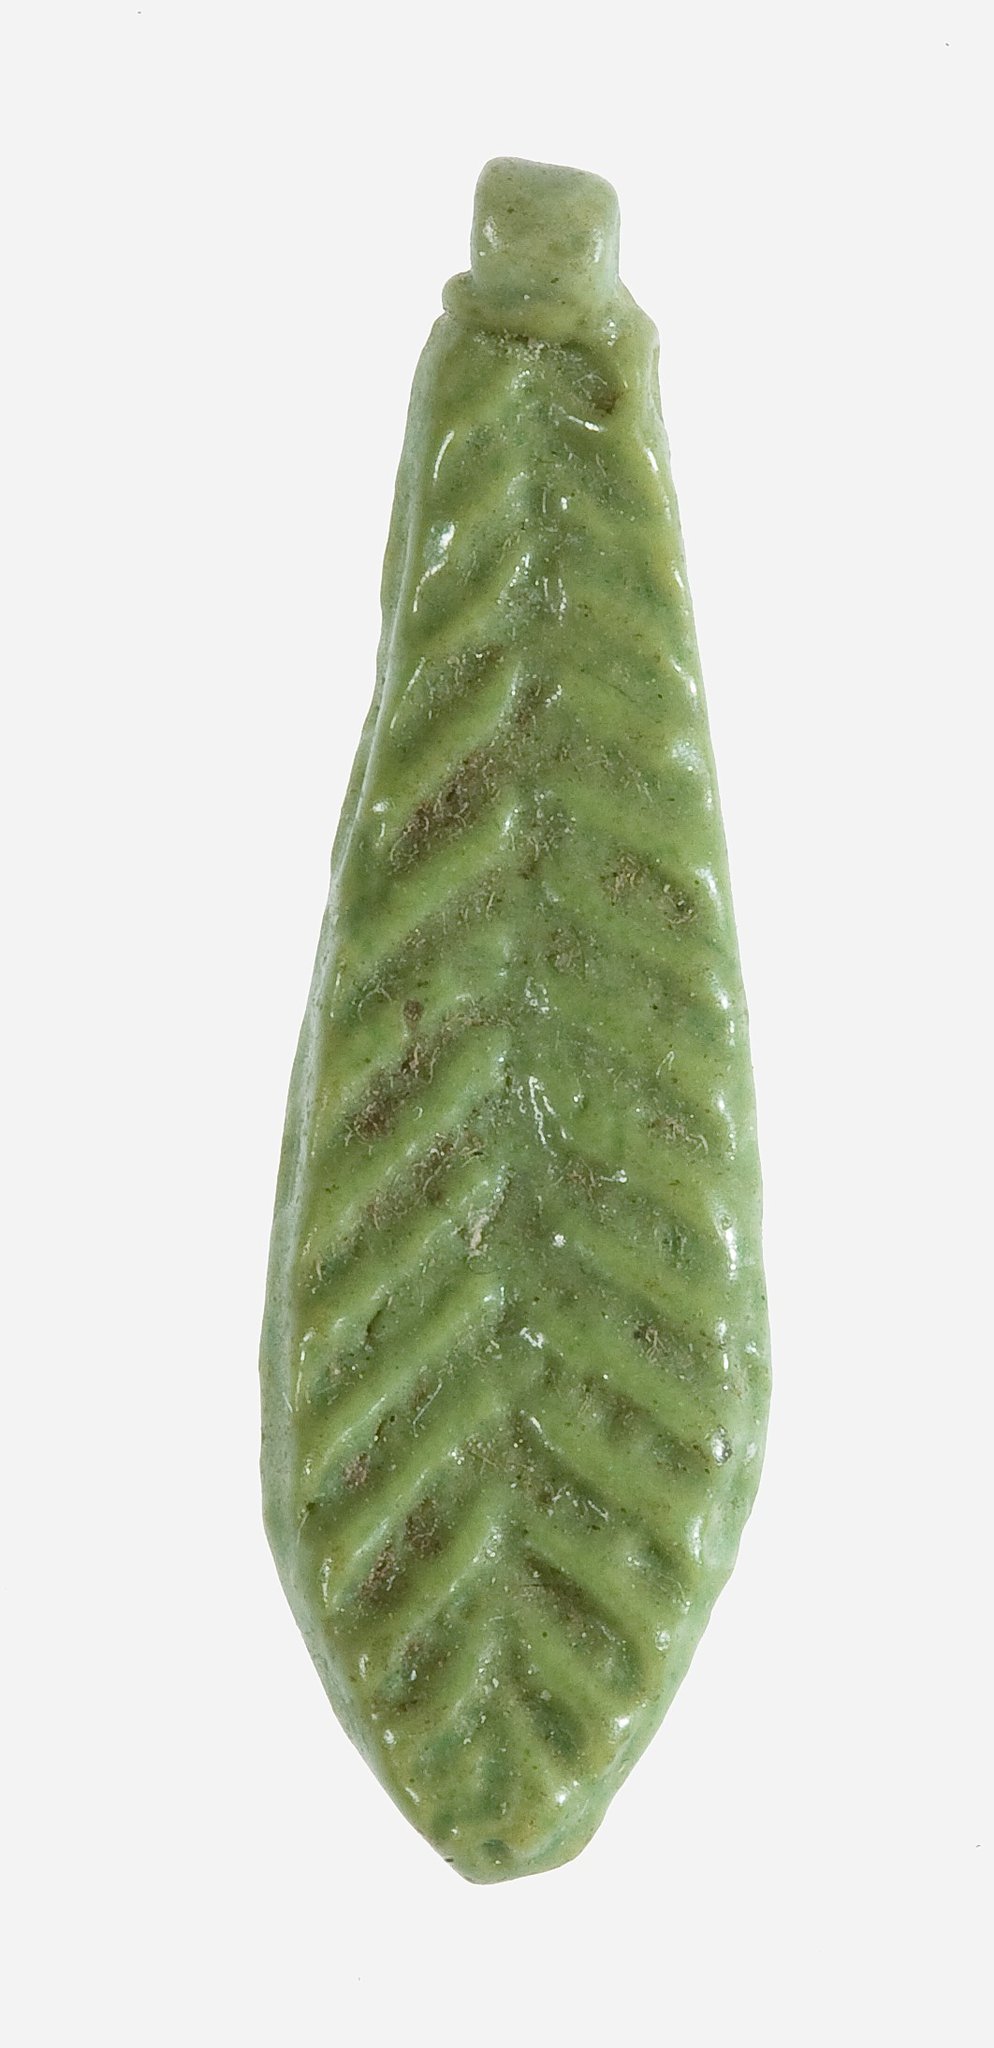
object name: bead, leaf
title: Leaf Bead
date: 1390-1352 BCE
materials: faience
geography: egypt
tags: leaves